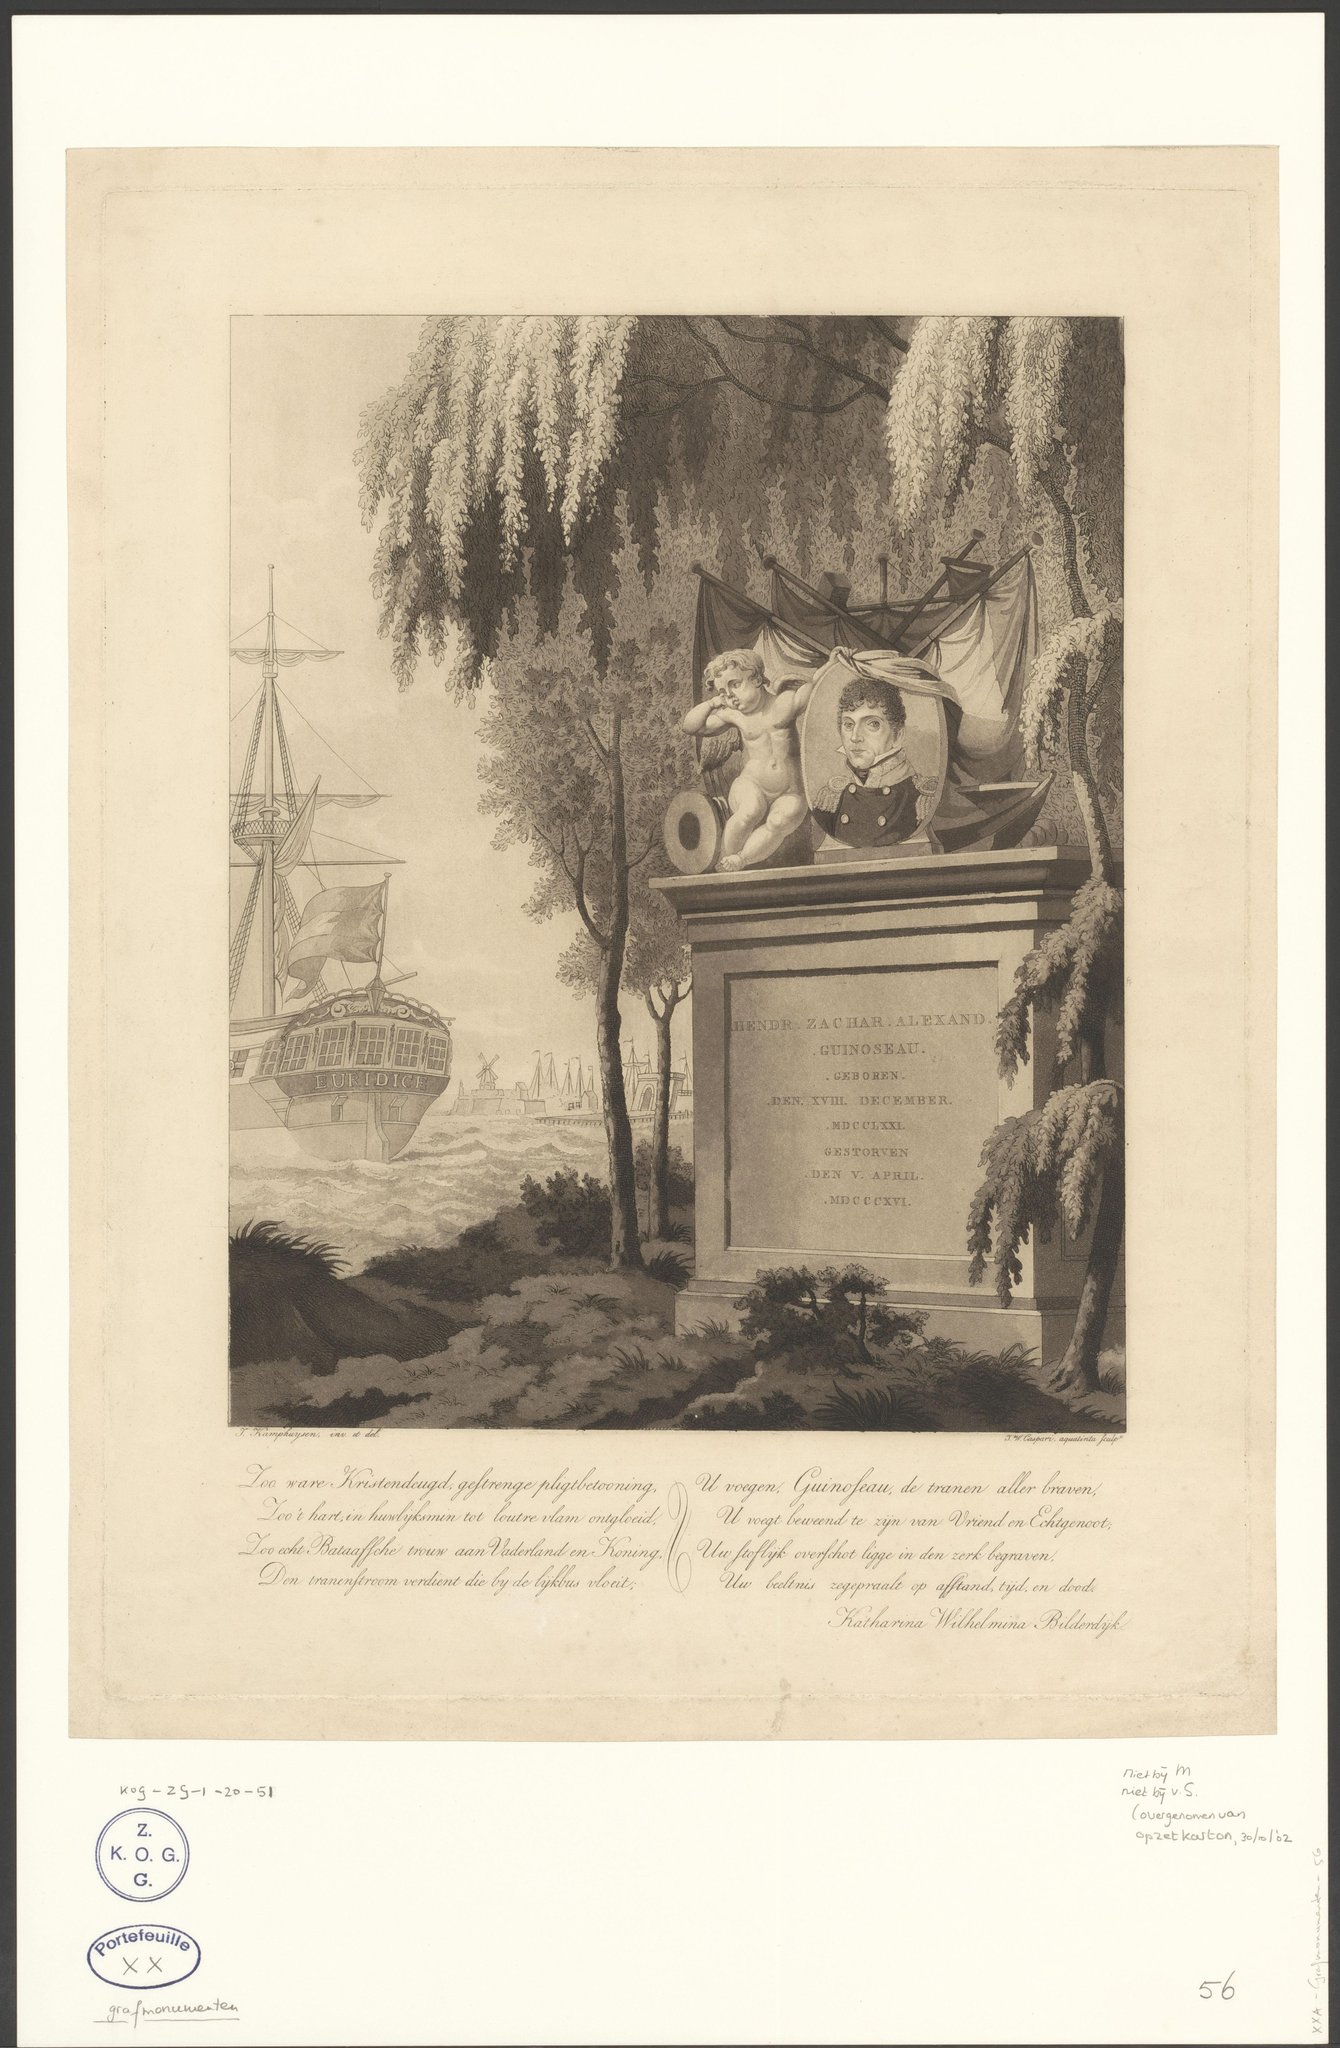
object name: print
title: Gedenkteken voor Hendrik Zacharias Alexander Guinoseau met portret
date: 1816-1822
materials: paper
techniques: aquatint, etching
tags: sailing-ship, sailing-boat, historical persons, warfare; military affairs (+ sailing-ships), cupids: 'amores', 'amoretti', 'putti'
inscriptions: stamp, collector's mark: Lugt 1641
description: Op de voorgrond een gedenkteken met opschrift en het portret van Hendrik Zacharias Alexander Guinoseau. Het portret wordt vastgehouden door een huilend engeltje Guinoseau heeft het uniform aan van de marine, buste naar links. Een treurwilg overschaduwt het graf. Op de achtergrond de contouren van een stad en het oorlogsfregat Euridice. De prent heeft een achtregelig Nederlands vers. Onderwerpsrubrieken binnen de Atlas Zeden en Gewoonten: Zeden en Gewoonten in Engeren Zin, Des menschen beging, midden en einde, Grafmonumenten.